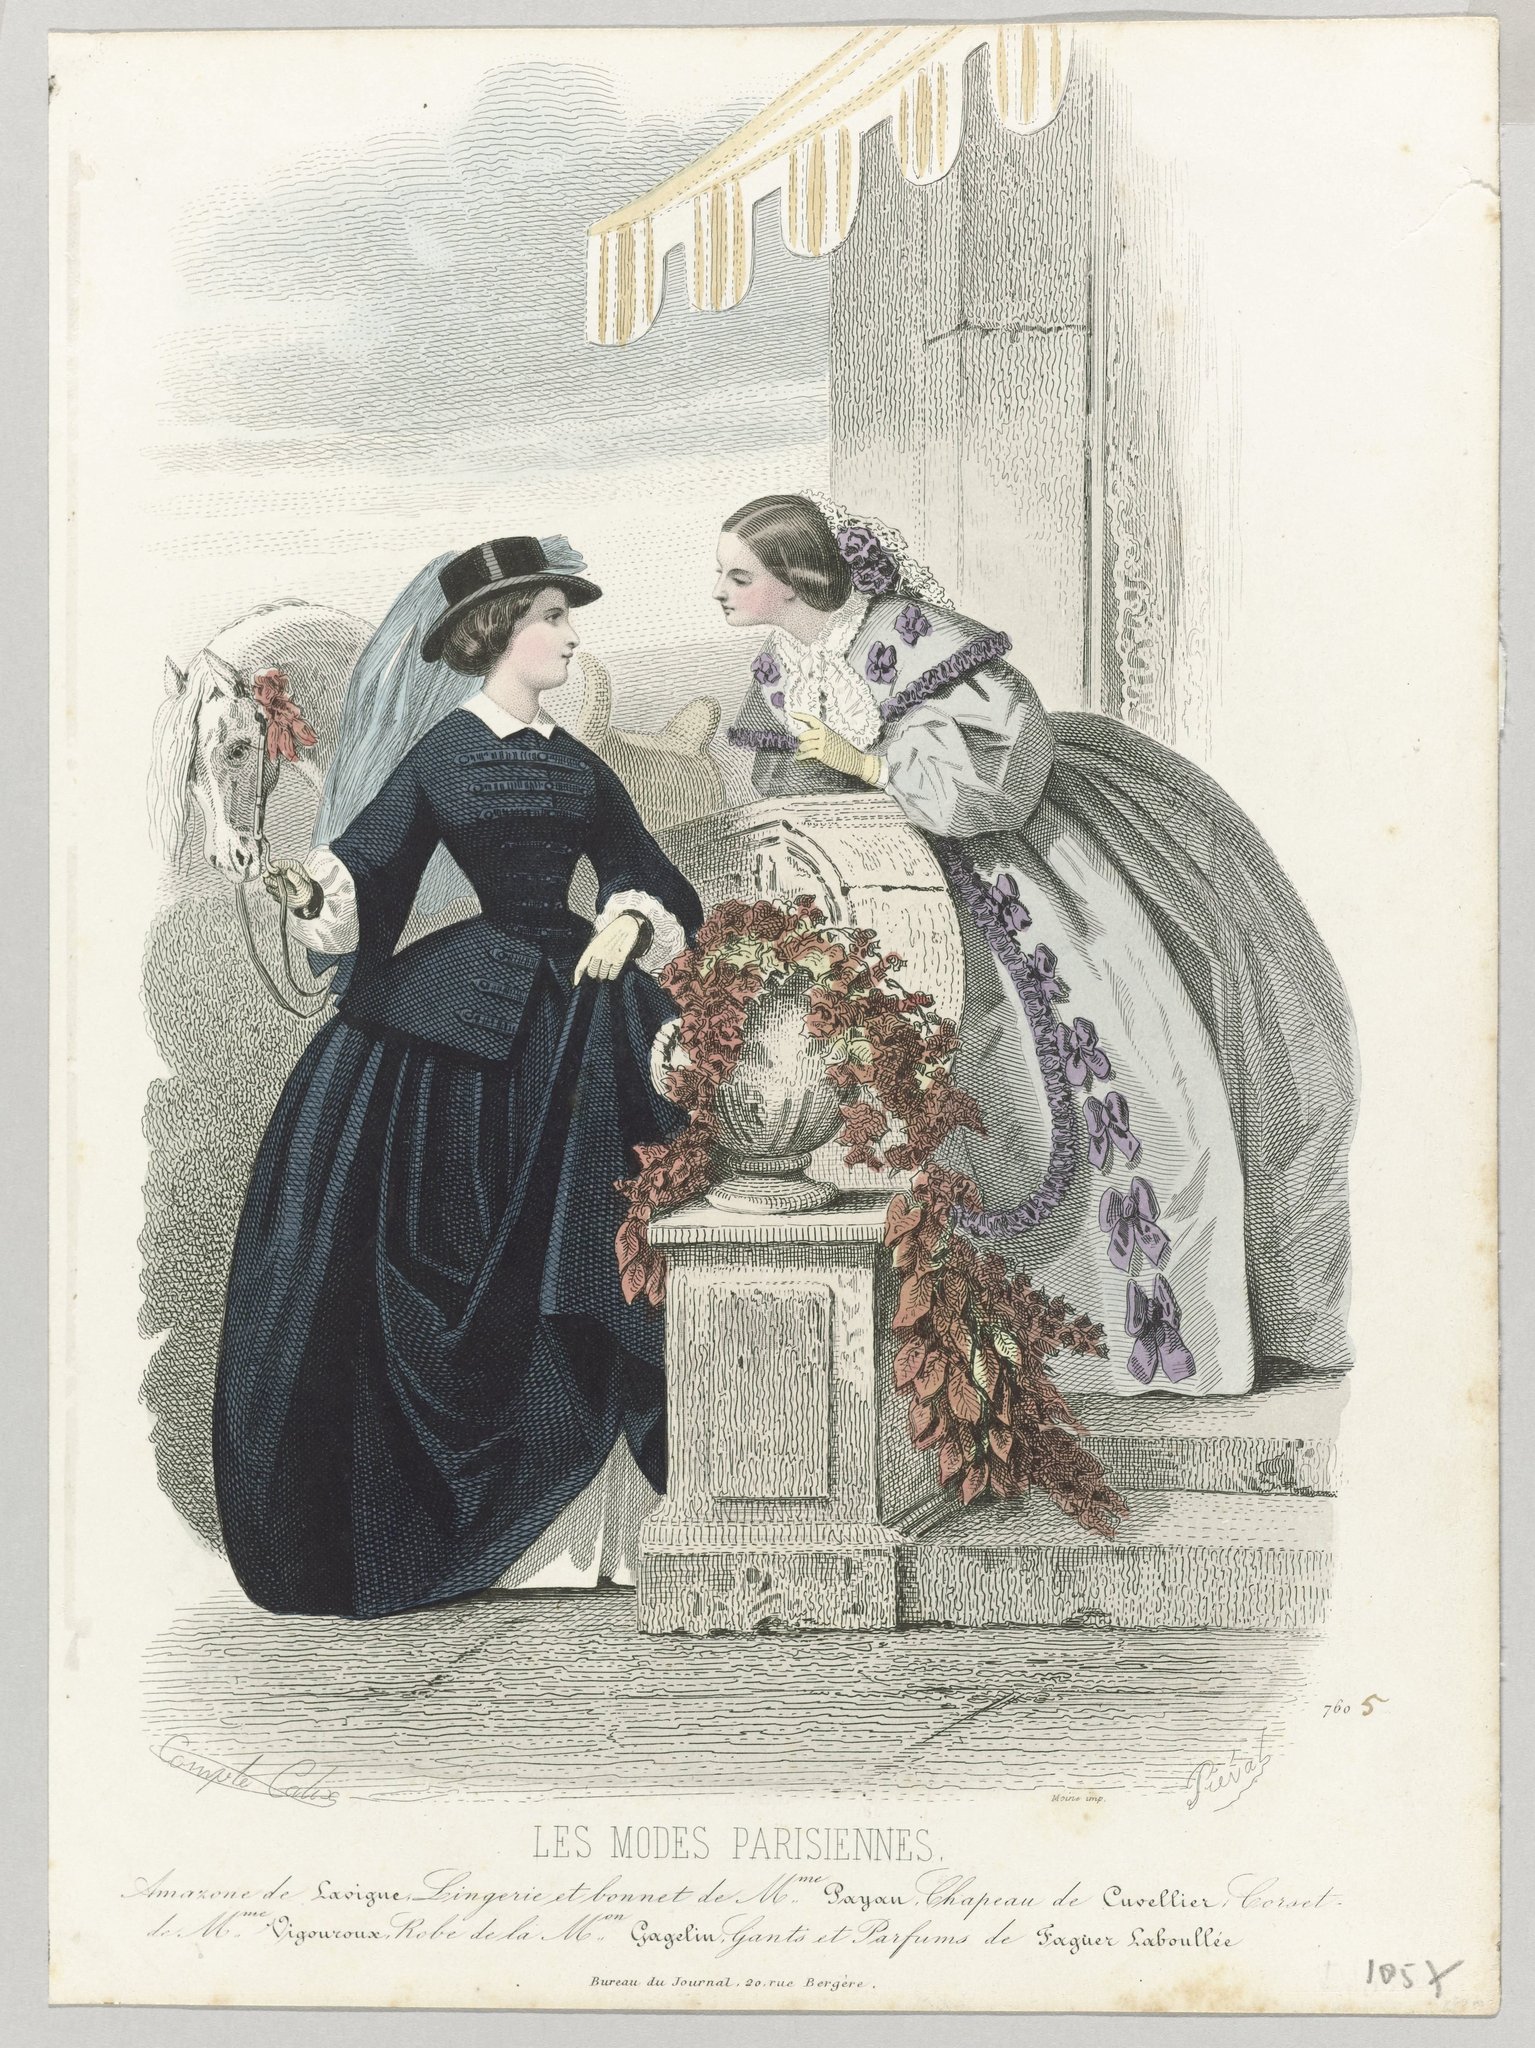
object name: fashion print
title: Les Modes Parisiennes, 1856, No. 760 : Amazone de Lavign (...)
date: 1856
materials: paper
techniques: engraving, hand coloring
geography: paris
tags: riding a horse, ass, or mule; rider, horseman (+ variant), veil (+ women's clothes), head-gear: cap (+ women's clothes), fashion plates, gloves, mittens, etc. (+ women's clothes), front steps, leading a horse by the reins; rider beside his horse, ensembles of pieces of clothing (riding costume) (+ women's clothes)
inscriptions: address: ‘Bureau du Journal, 20, rue Bergère.’, caption: ‘Amazone de Lavigne, Lingerie et bonnet de M"me Payan, Chapeau de Cuvellier, Corset de M"me Vigouroux, Robe de la M"on Gagelin, Gants et Parfums de Faguer Laboullée’, title: ‘Les Modes Parisiennes.’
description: Een vrouw met een paard aan de teugels praat met een vrouw op een bordes. Volgens het onderschrift: amazonekostuum (rijkostuum) van Lavigne. Hieronder enkele regels reclametekst voor verschillende producten. Prent uit het modetijdschrift Les Modes Parisiennes (1843-1885).